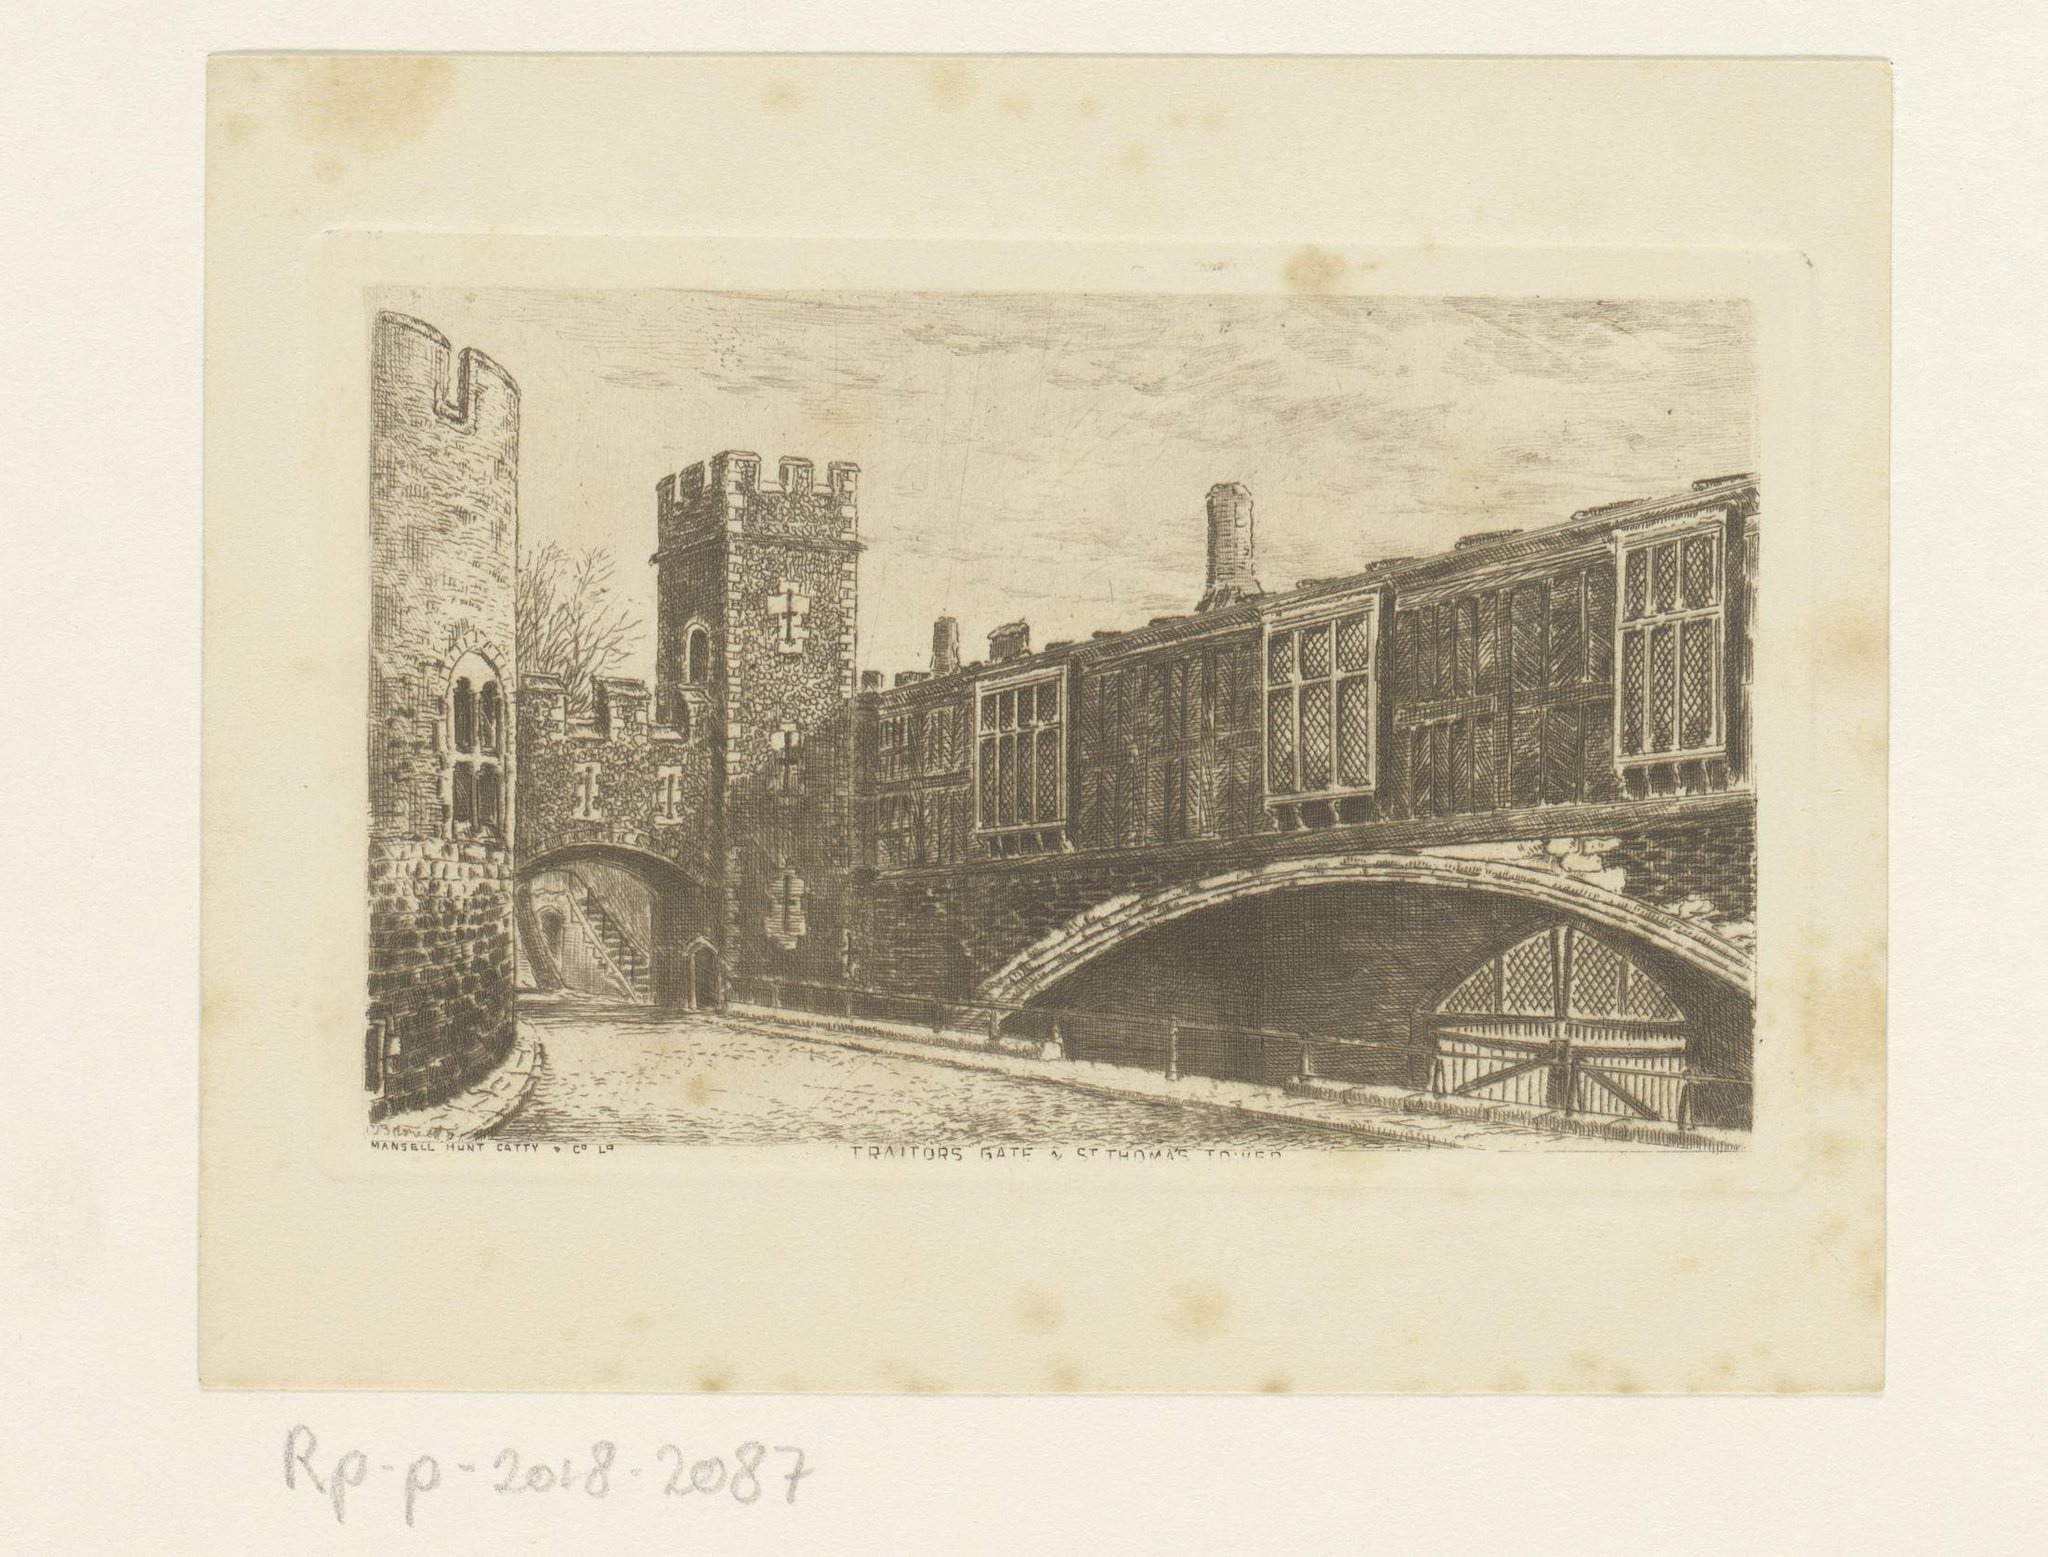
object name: print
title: Gezicht op de Traitors Gate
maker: Anonymous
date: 1850-1949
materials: paper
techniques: etching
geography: london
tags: fortress, gate, entrance, tower (of house or building)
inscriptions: collector's mark: Lugt 2228